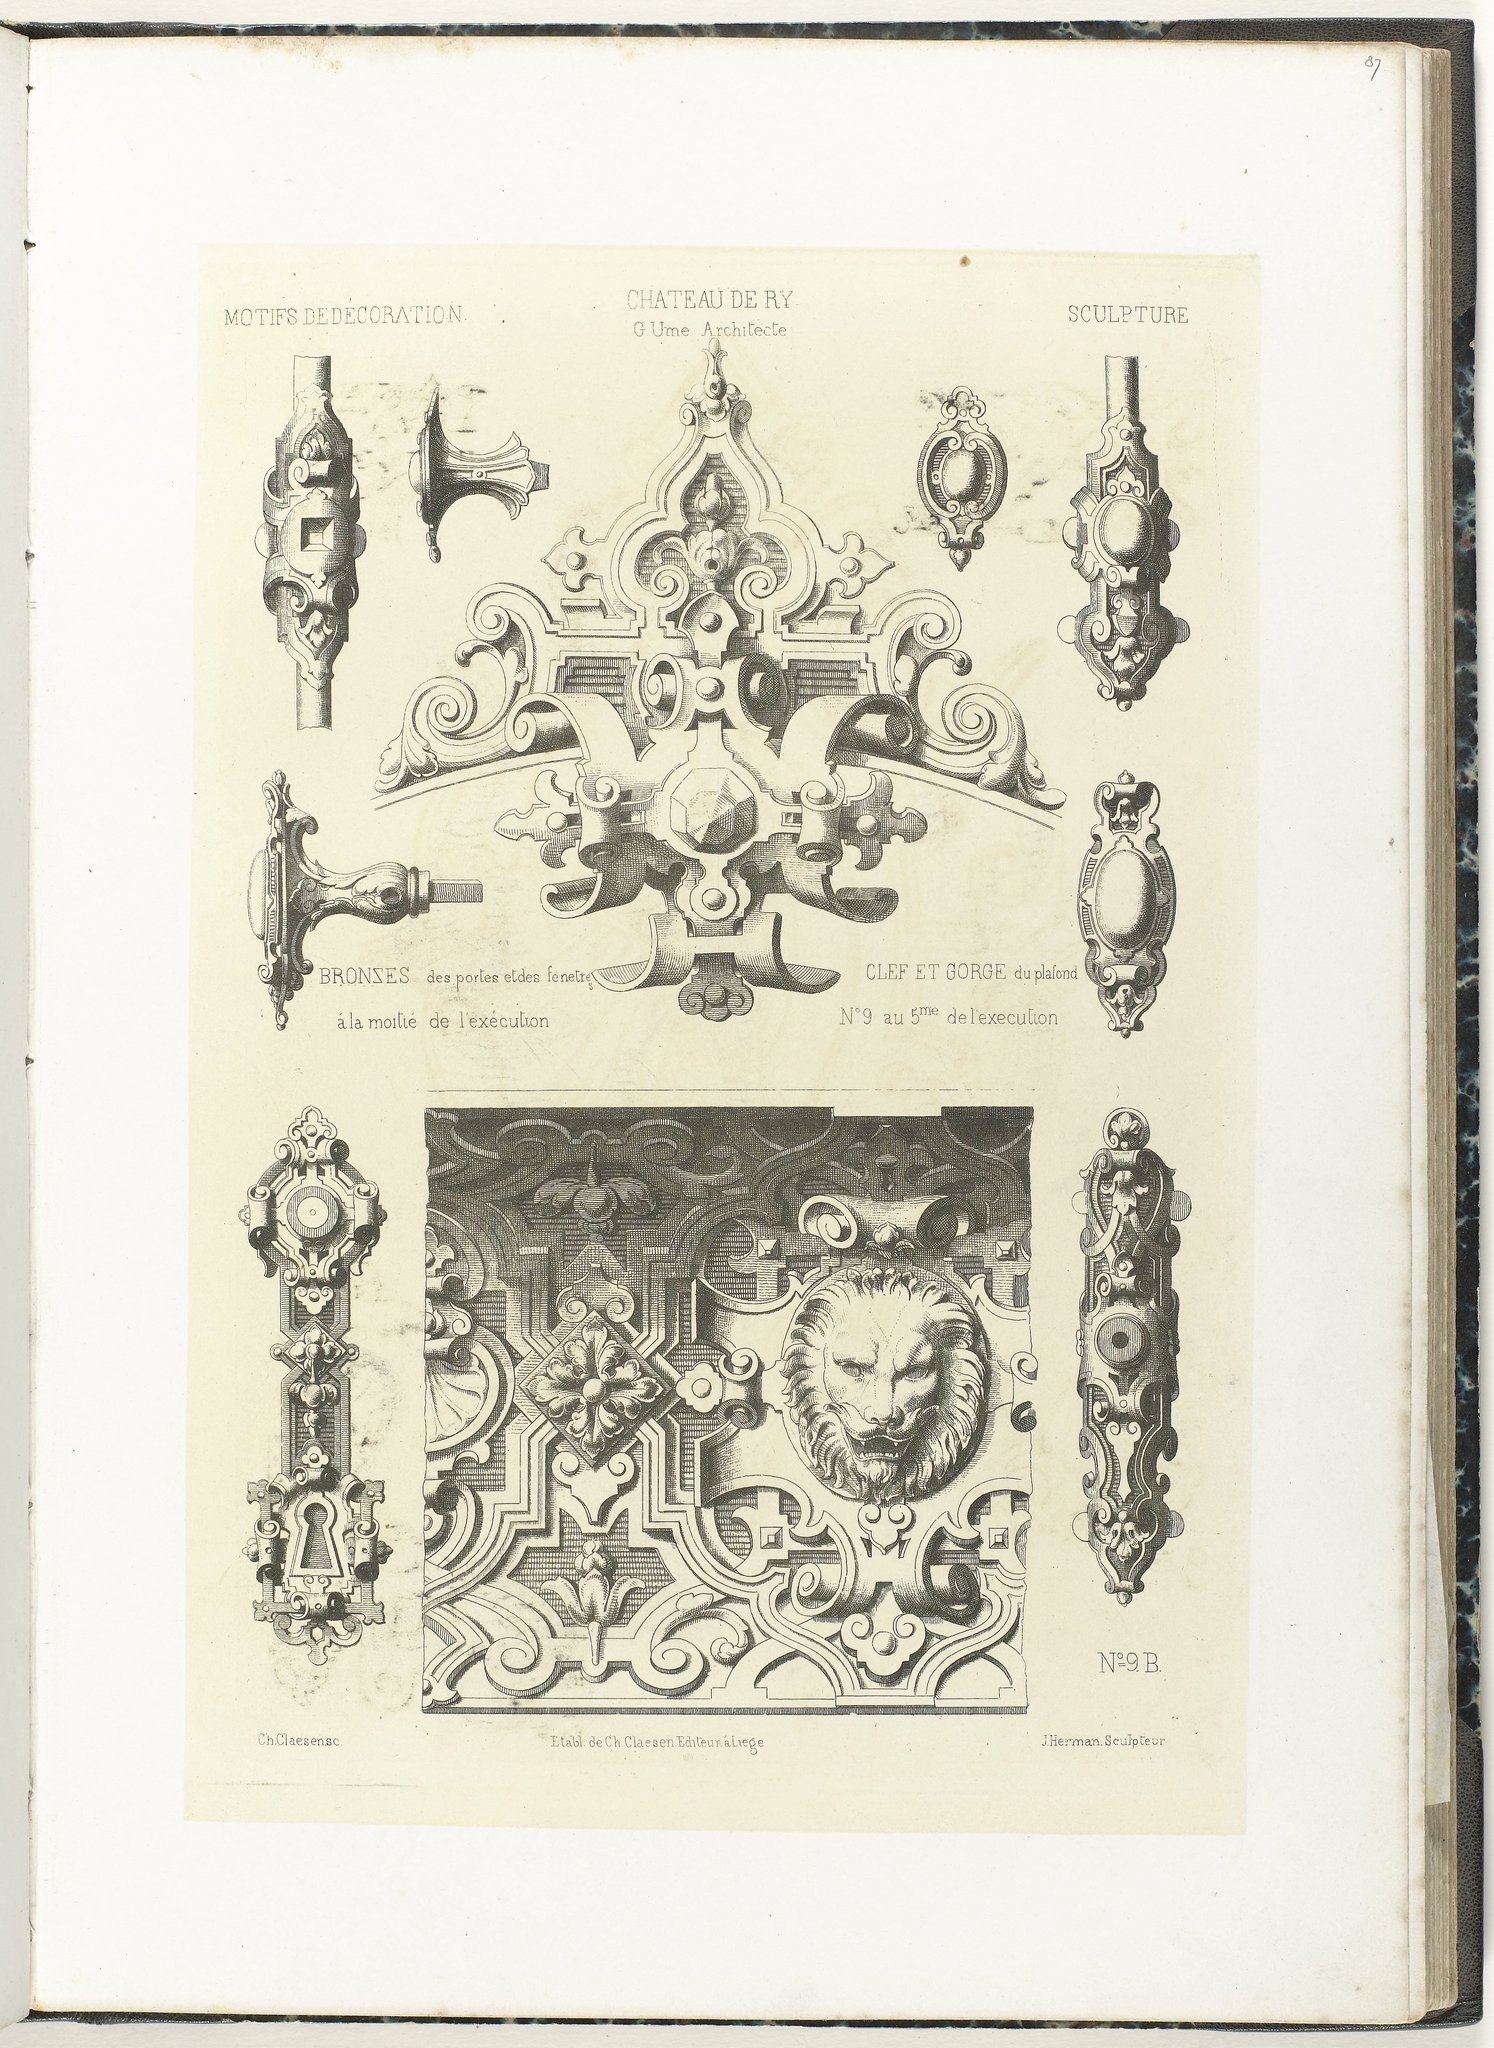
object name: print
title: Chateau de Ry / G Ume Architecte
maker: j. herman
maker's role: designer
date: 1866-1900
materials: paper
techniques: tone lithography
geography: liège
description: Bronzen details van poorten en vensters van het kasteel van Ry, zoals handvatten en sleutelgaten. Linksboven staat vermeld: Motifs de décoration, rechtsboven: Sculpture, rechtsonder: N° 9.B.